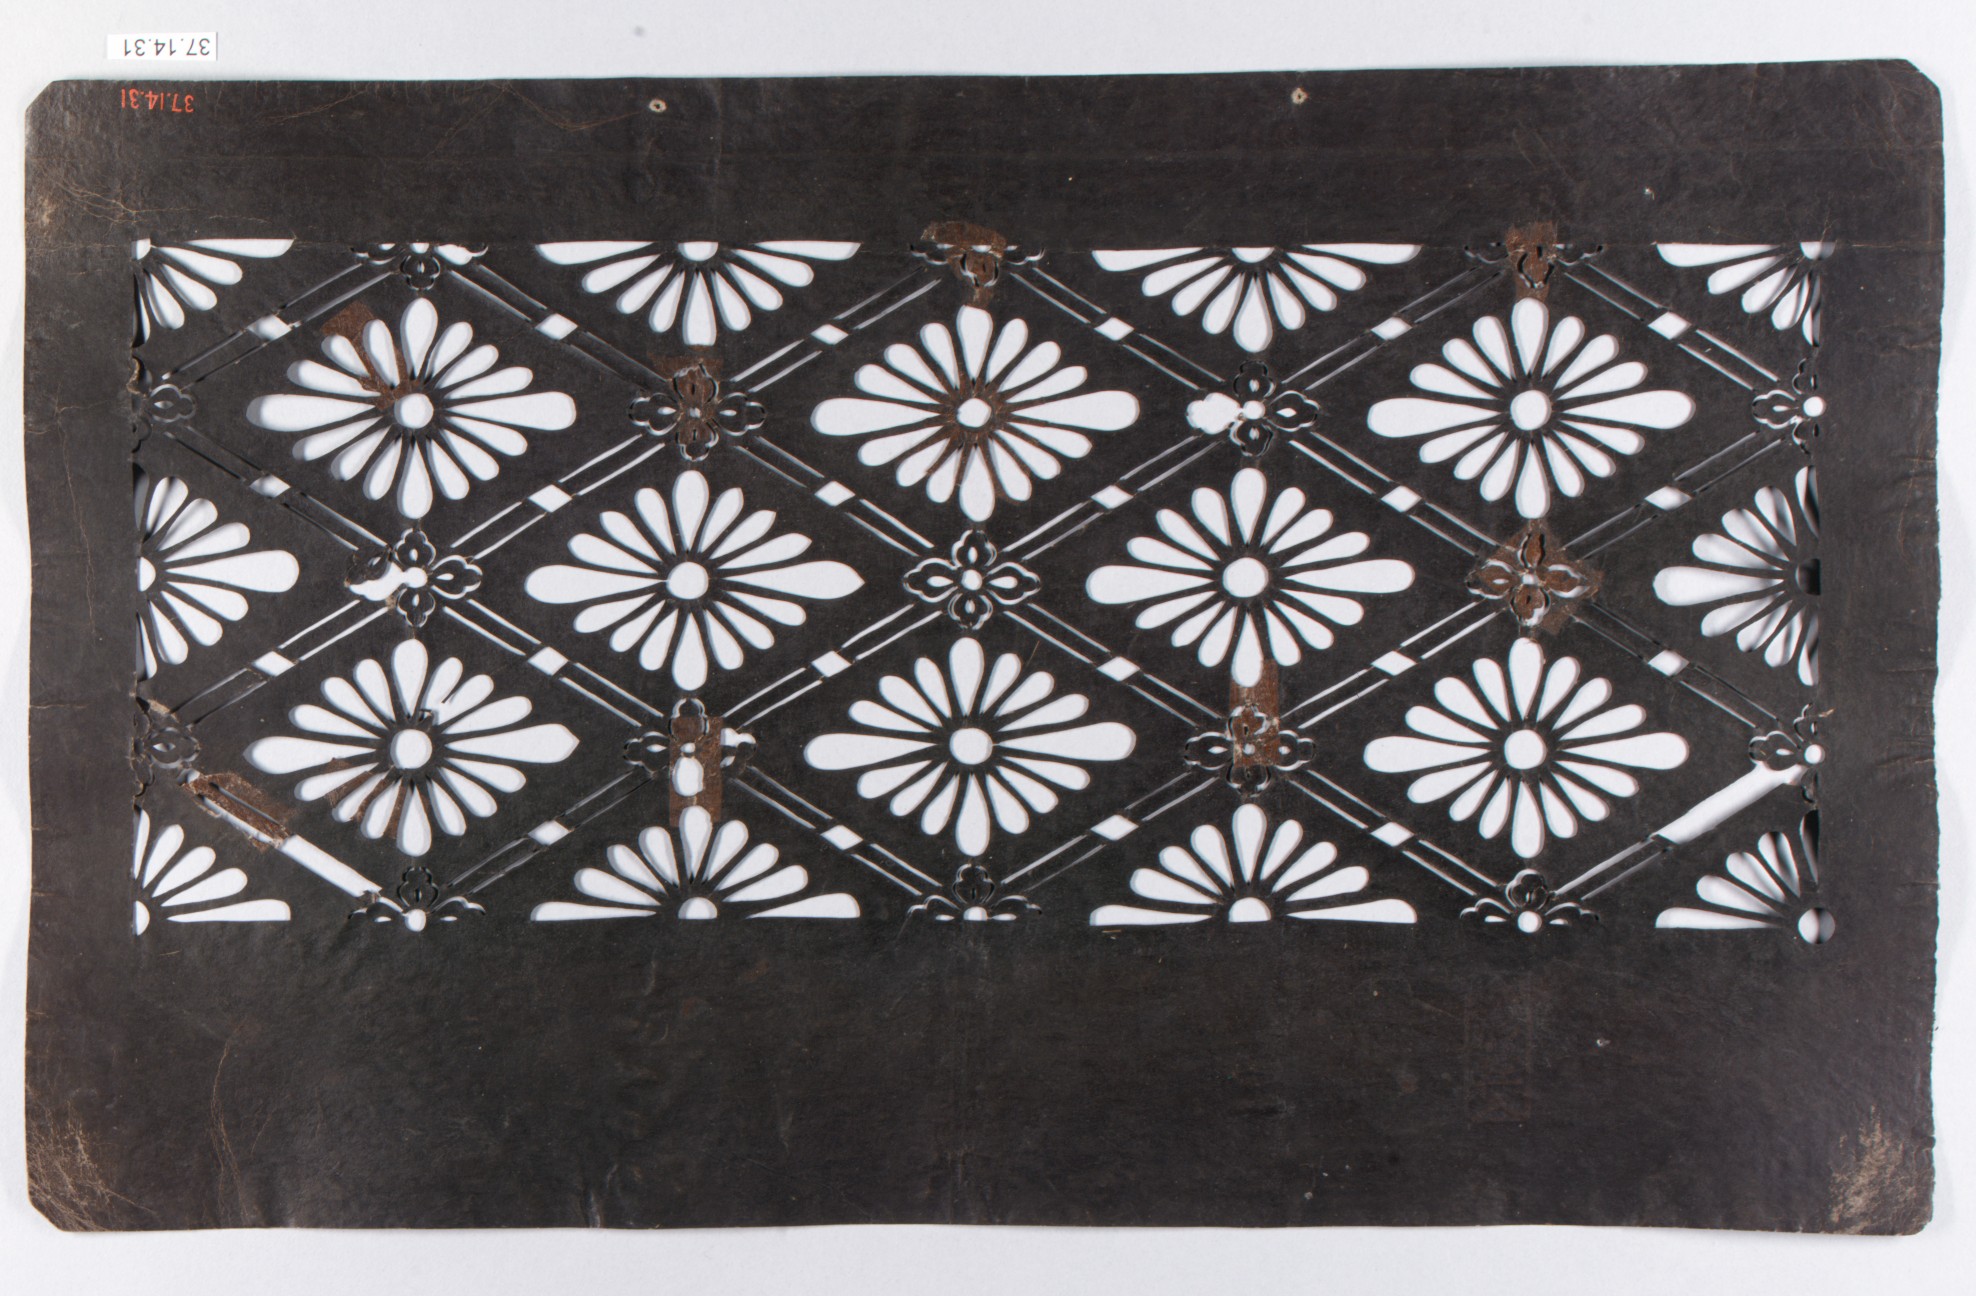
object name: stencil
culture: japanese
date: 1801-1833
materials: paper